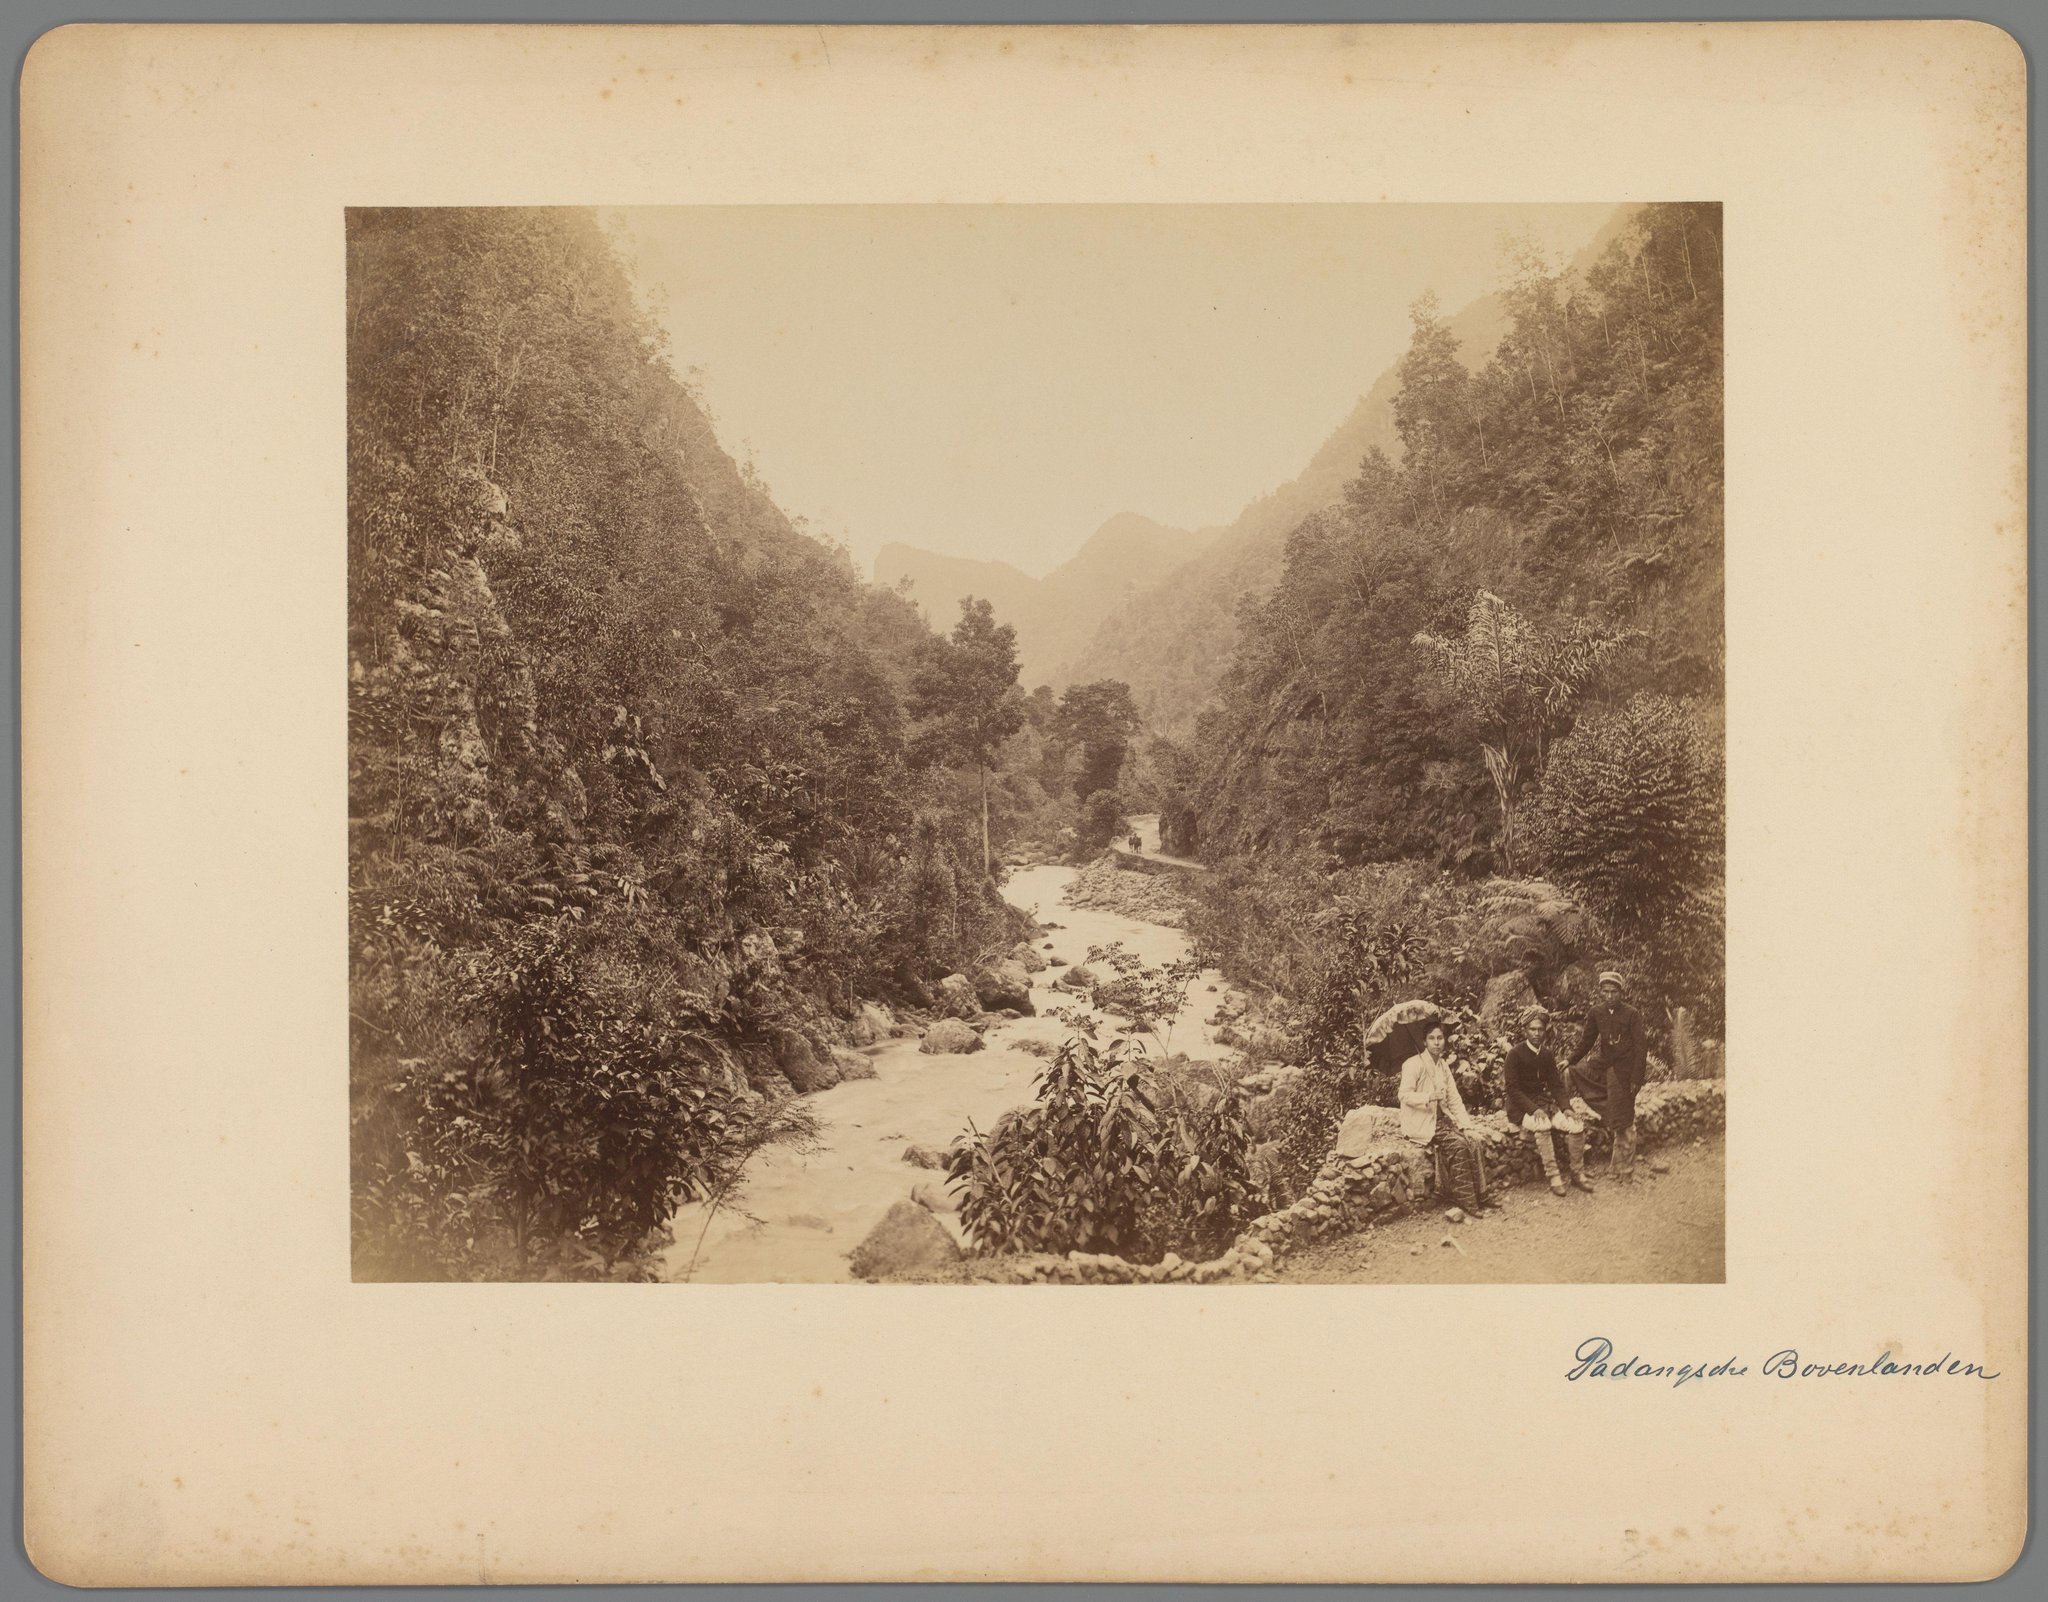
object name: photograph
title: Padangsche Bovenlanden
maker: christiaan benjamin nieuwenhuis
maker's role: publisher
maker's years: 1863-1922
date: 1891-1912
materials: cardboard, paper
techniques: albumen print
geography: sumatera barat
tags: river, dale, valley (+ landscape with figures, staffage), sumatera barat (province)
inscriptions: inscription: ‘FOTO’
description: Deze foto zat oorspronkelijk in prentenkabinet RP-F-AA3192.